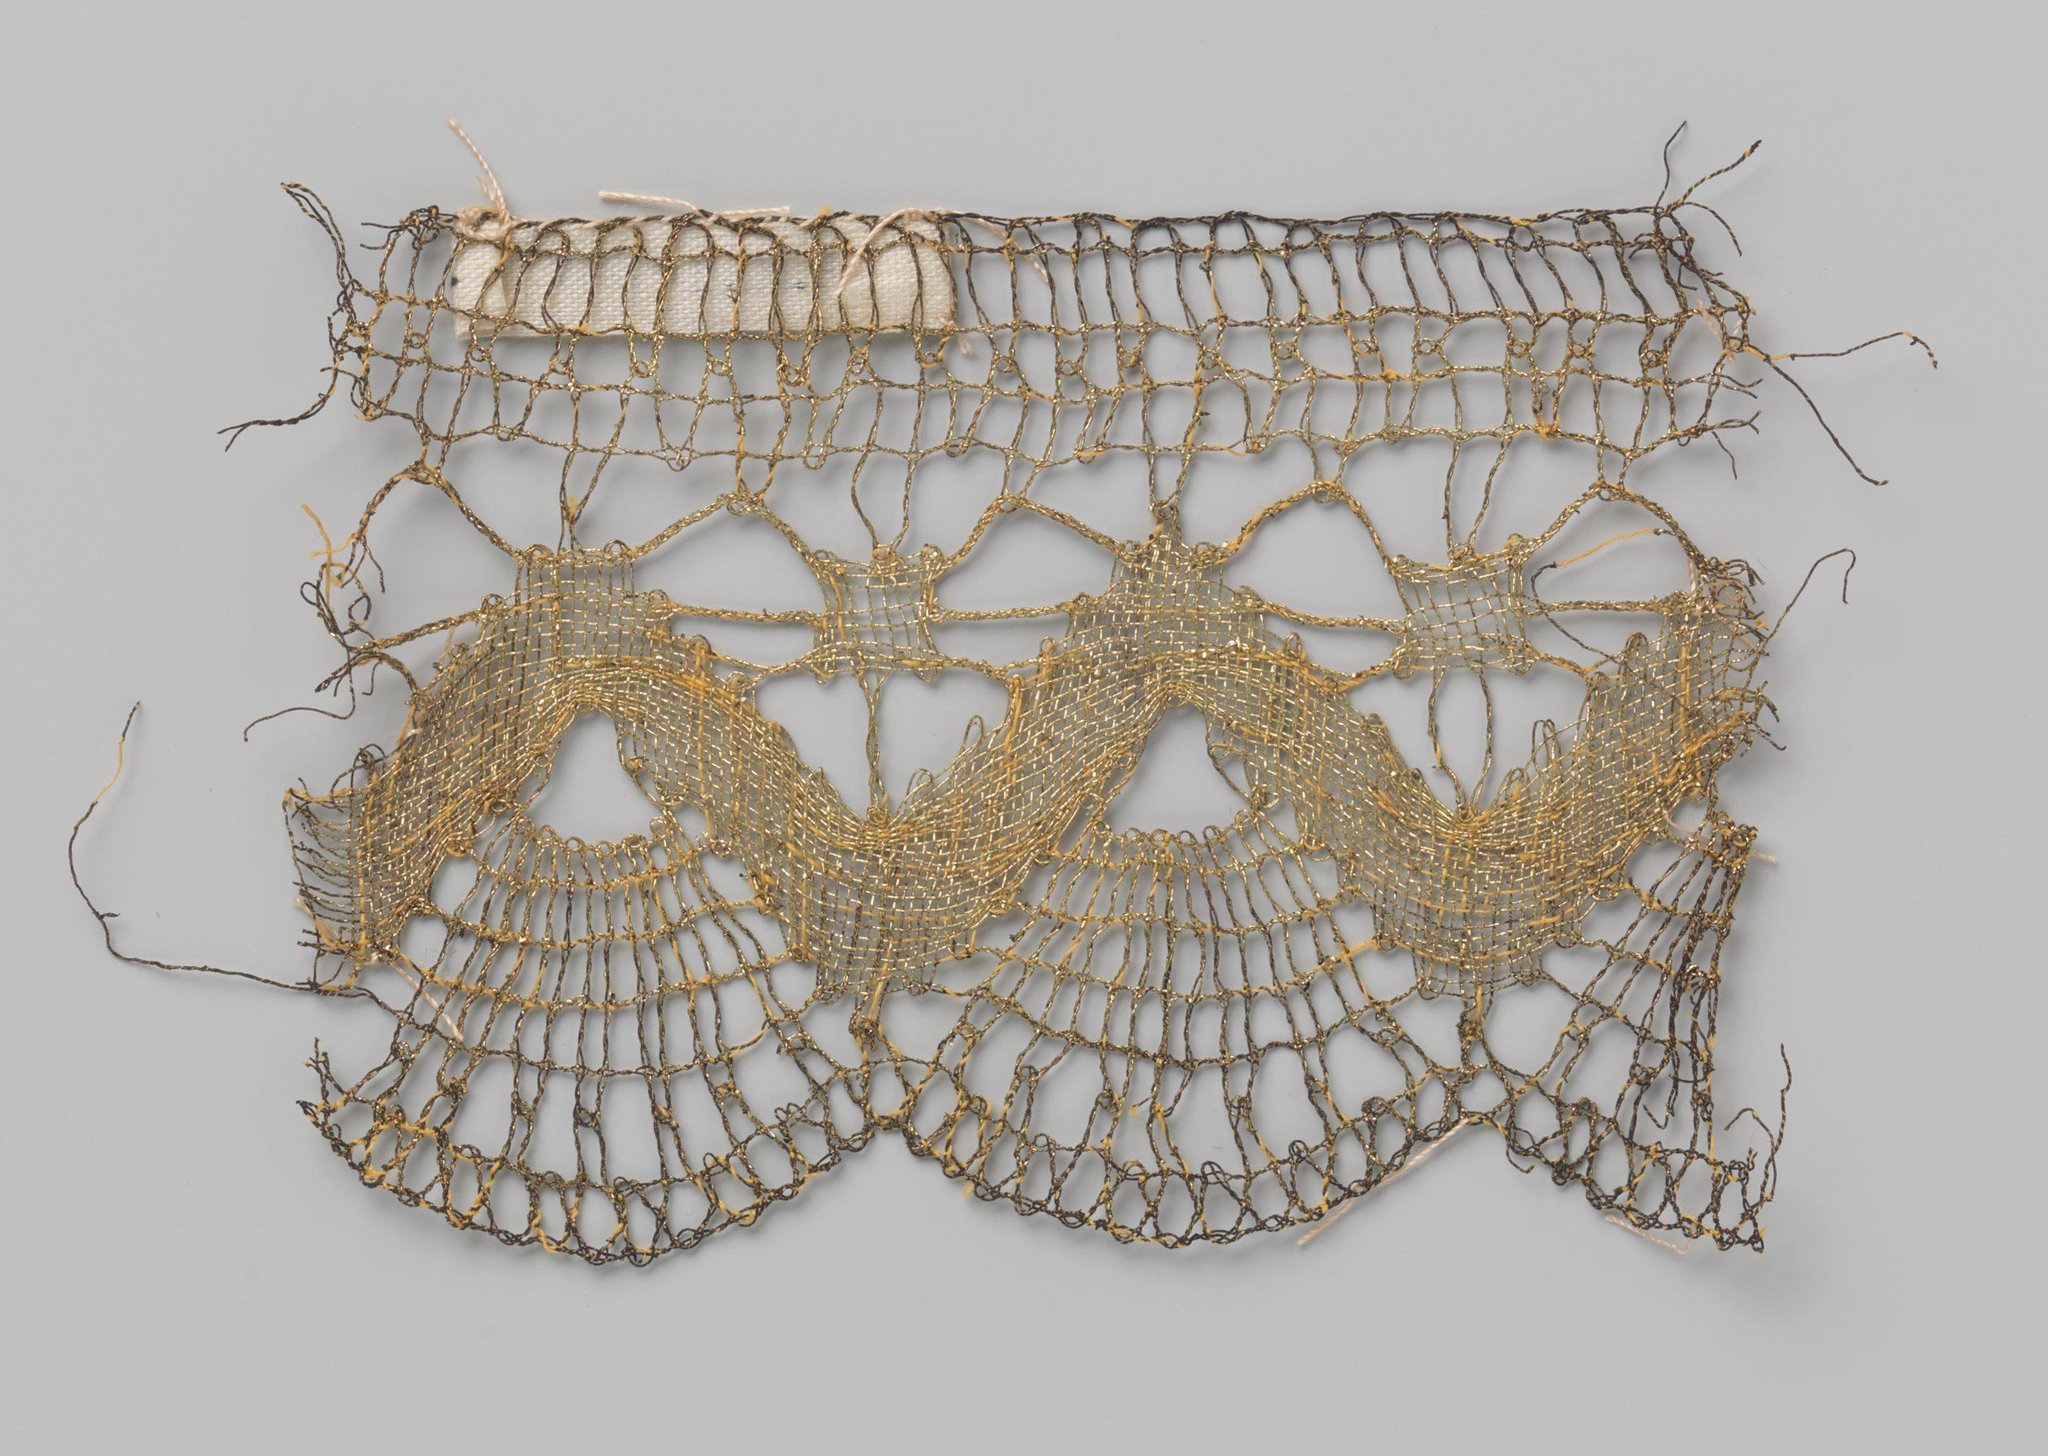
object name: strip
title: Strook goudkant met zigzag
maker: Anonymous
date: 1900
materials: gold thread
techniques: lace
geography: russia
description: Strook kloskant, goudkant. Het patroon bestaat uit een band die in zigzag over de middenlijn loopt. In elk zigzag-dal staat een vierkantje en onder elke top hangt een waaiervormige schulp. De bovenzijde van de strook is recht afgewerkt. De zigzag-band en vierkantjes zijn gemaakt in linnenslag en zijn met elkaar verbodnen door spijlen en gedraaide paren. De bovenrand van de strook en de schulpen bestaan uit gedraaide paren, die door elkaar gevlochten zijn.